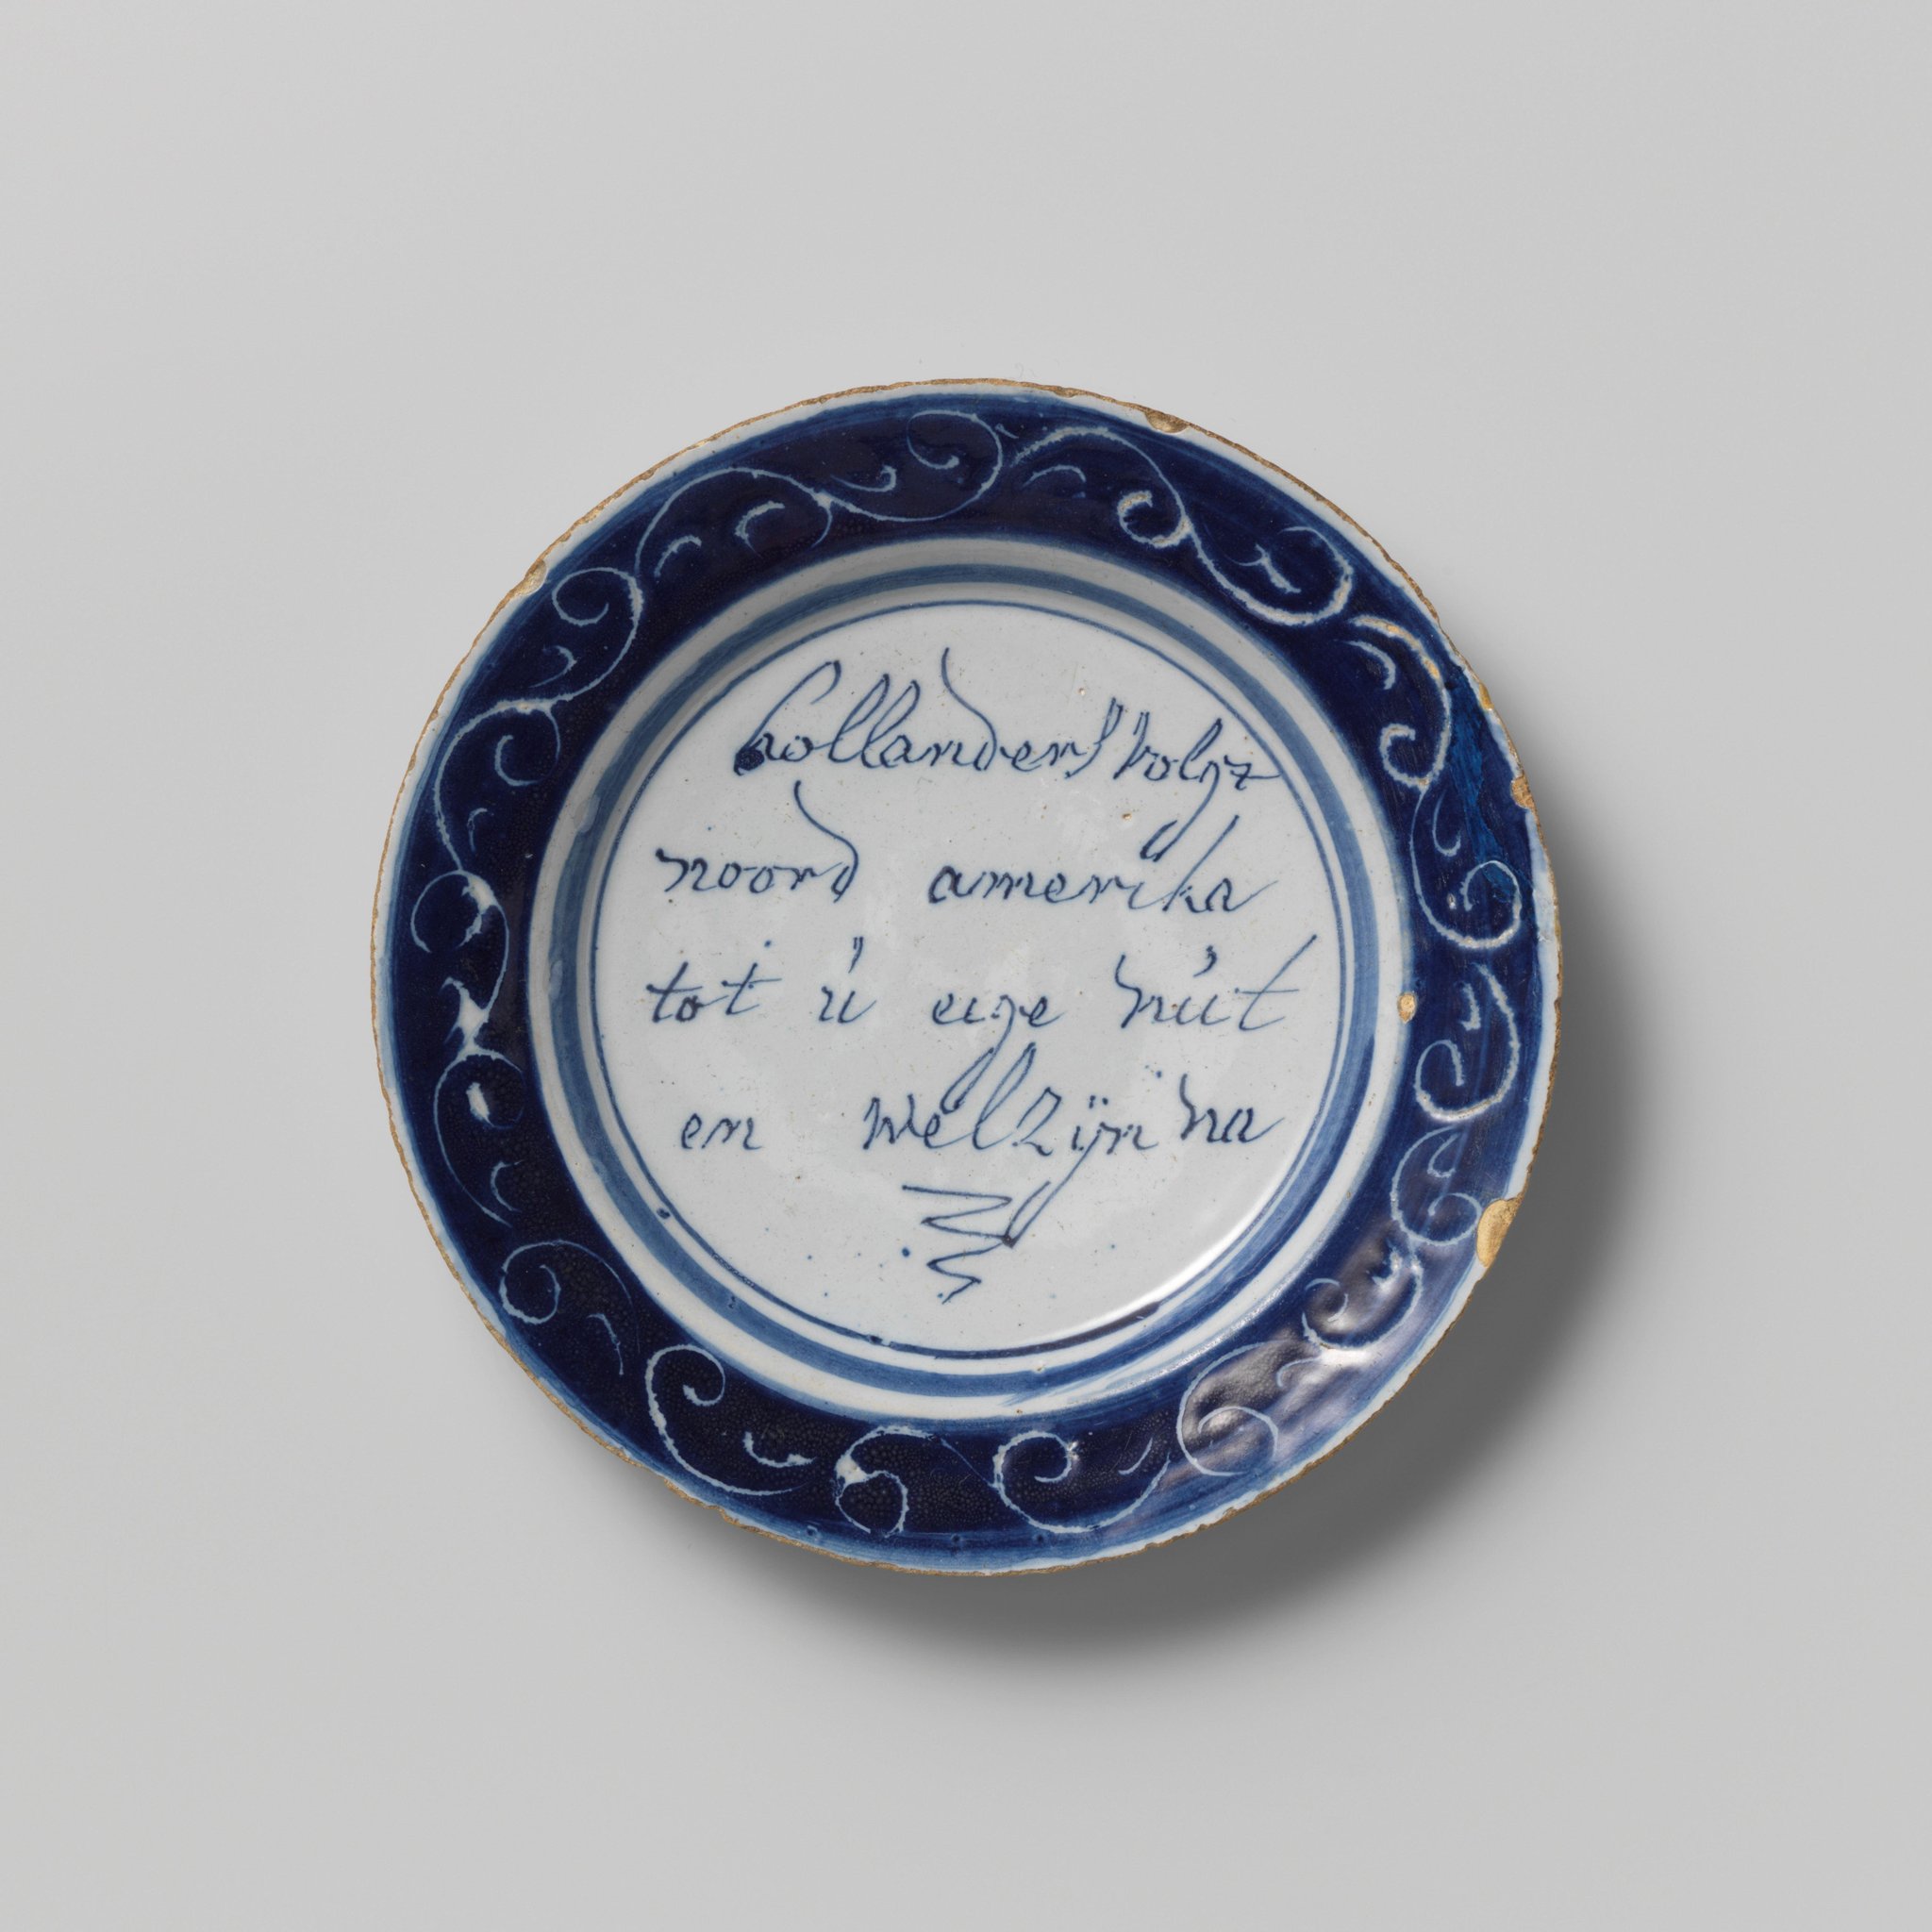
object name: plate dish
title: Hollanders volgt Noord-Amerika tot uw eigen nut en welzijn na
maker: Anonymous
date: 1780-1799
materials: earthenware, glaze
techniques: painted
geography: netherlands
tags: united states of america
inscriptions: inscription: ‘hollanders volgt / noord amerika / tot ù eige nùt / en welzijn na’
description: Plate with the inscription 'Hollanders follow North America for your own benefit and welfare', 1780-1800. The War of Independence of the British colonies in North America (1773-1776) was a source of inspiration for the Dutch Patriots. Especially impressive were the colonial militias of armed citizens.